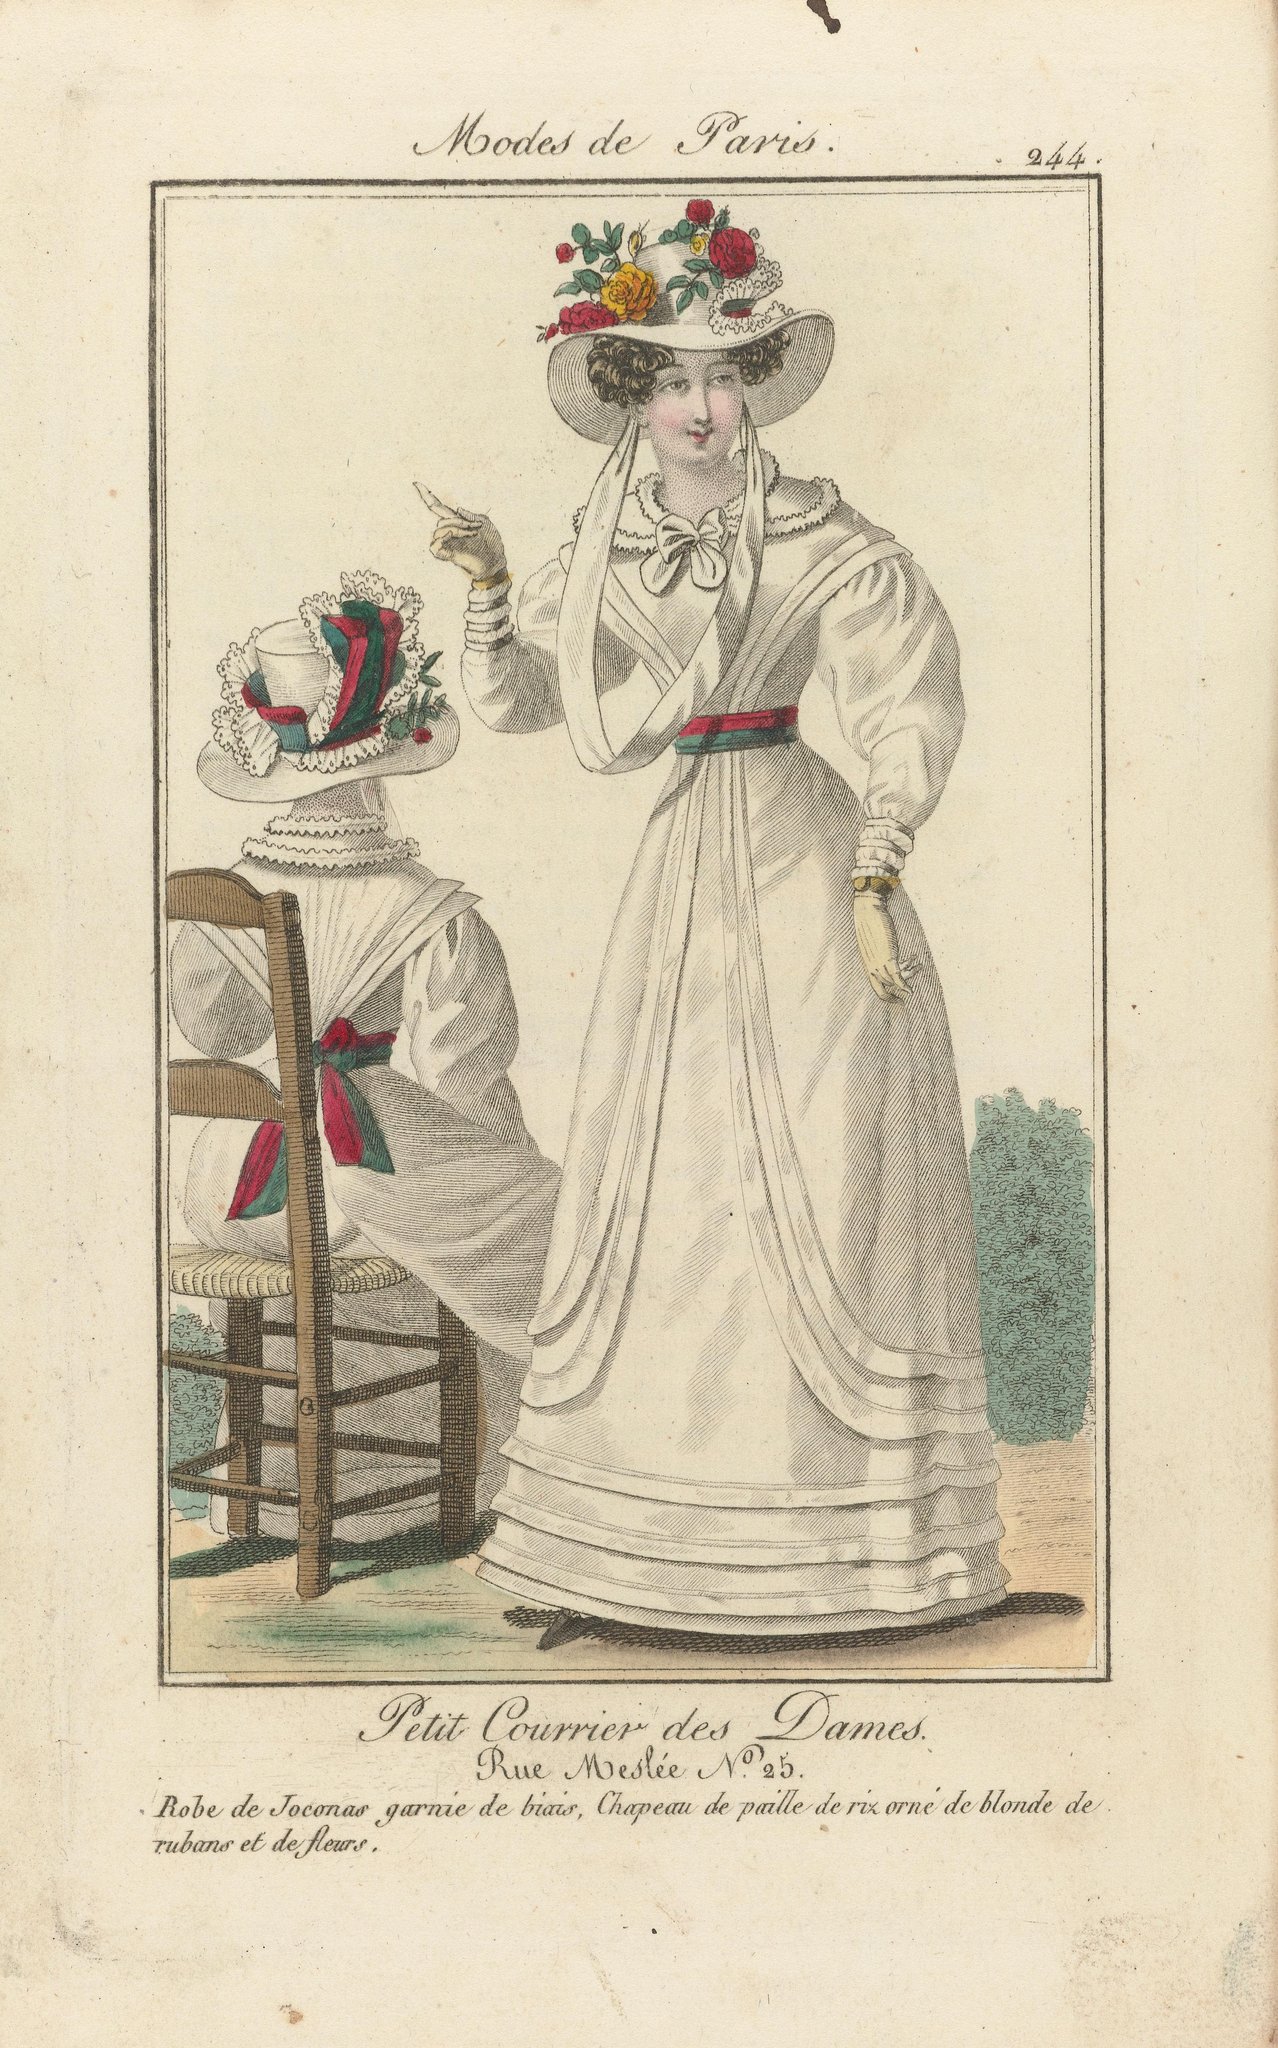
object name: magazine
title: Petit Courrier des Dames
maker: Anonymous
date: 1824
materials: paper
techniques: engraving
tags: fashion plates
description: Prent uit het modetijdschrift Petit Courrier des Dames (1821-1868).